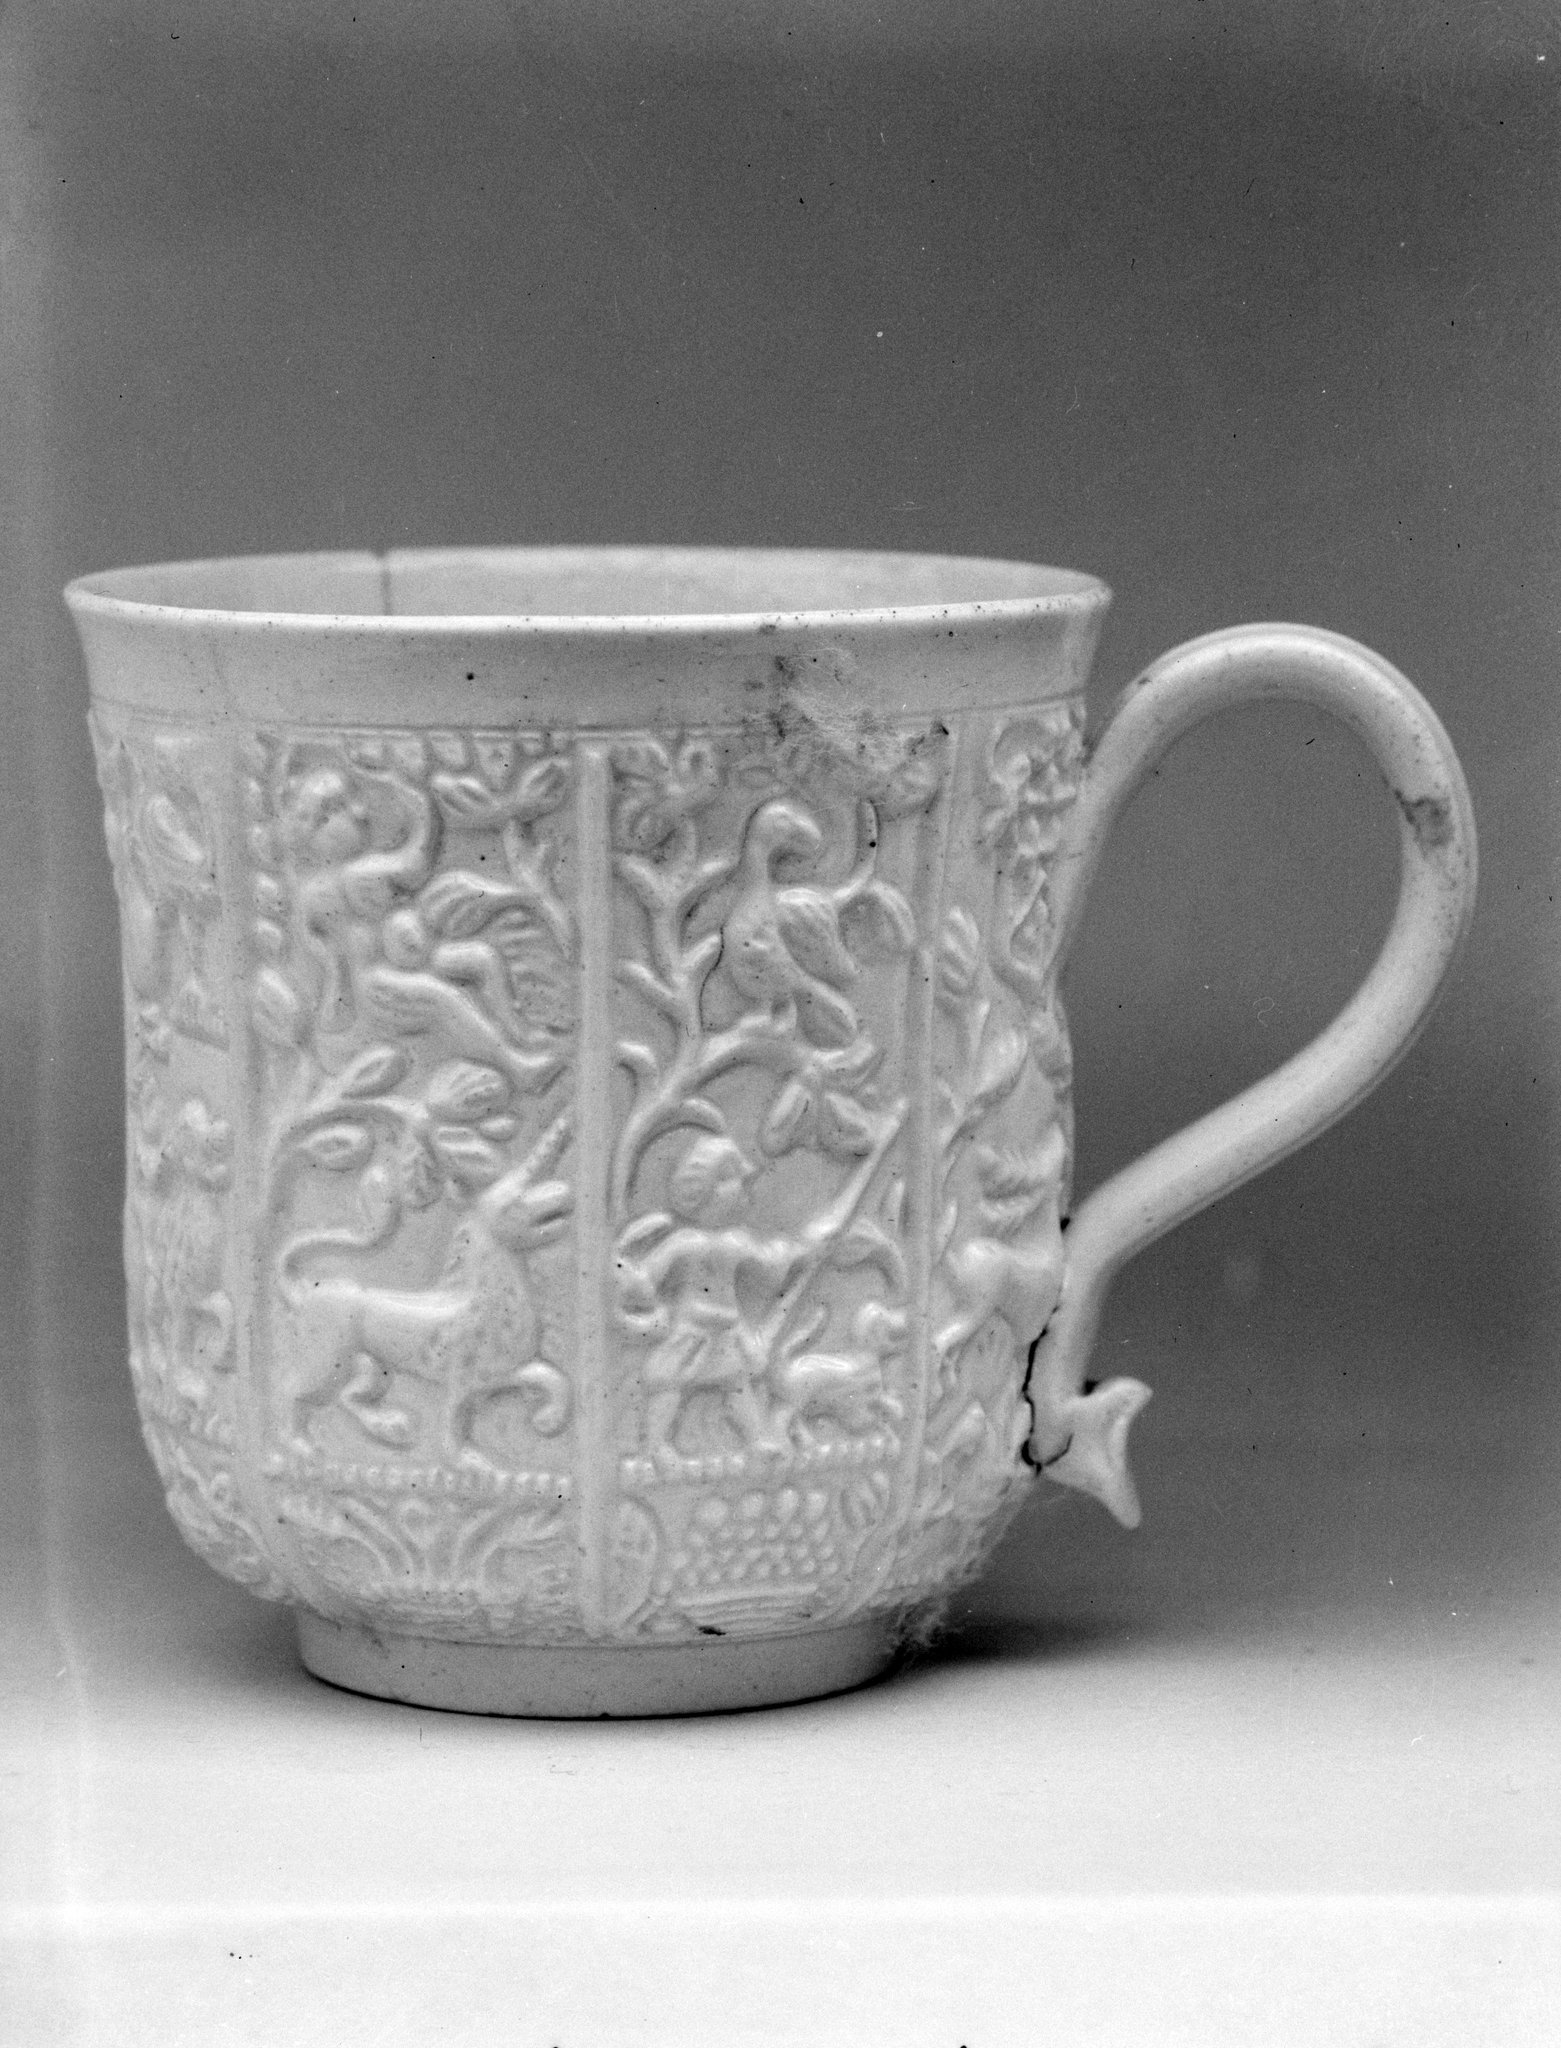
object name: cup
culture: british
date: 1740-1750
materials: stoneware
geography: england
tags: birds,men